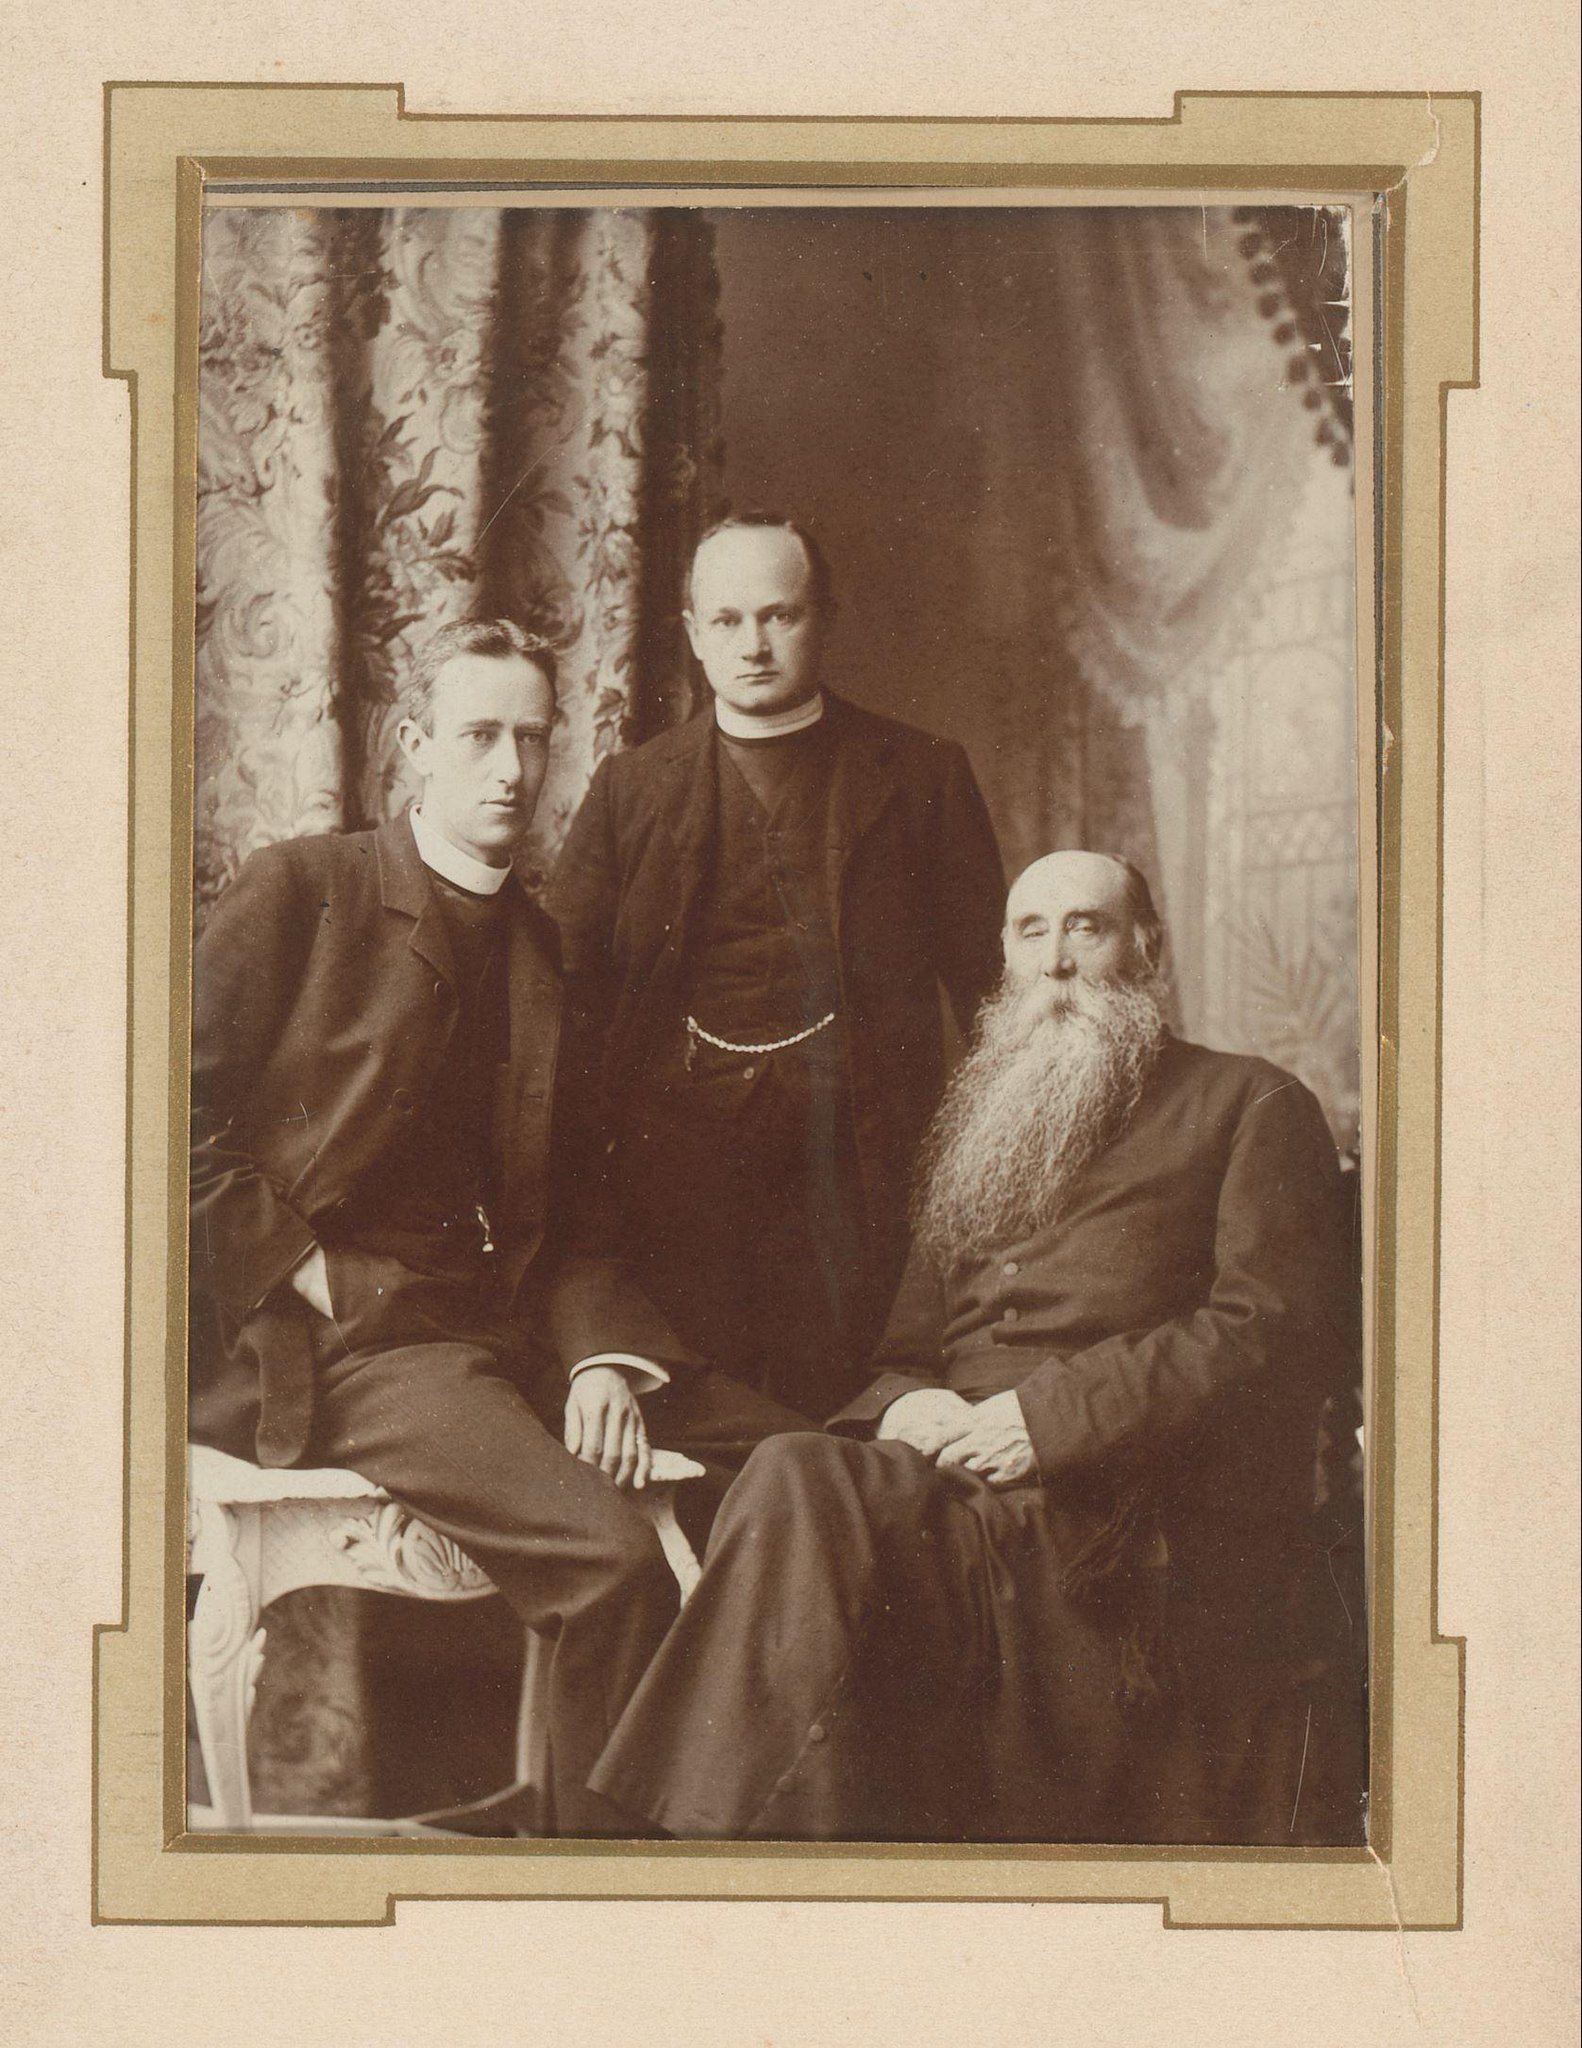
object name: photograph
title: Portret van een drie mannen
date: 1880-1920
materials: cardboard, photographic support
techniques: collodion silver print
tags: adult man, historical persons, beard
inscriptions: inscription: ‘Heawood & Hargrave/ King Richard's Rd/ Leicester’